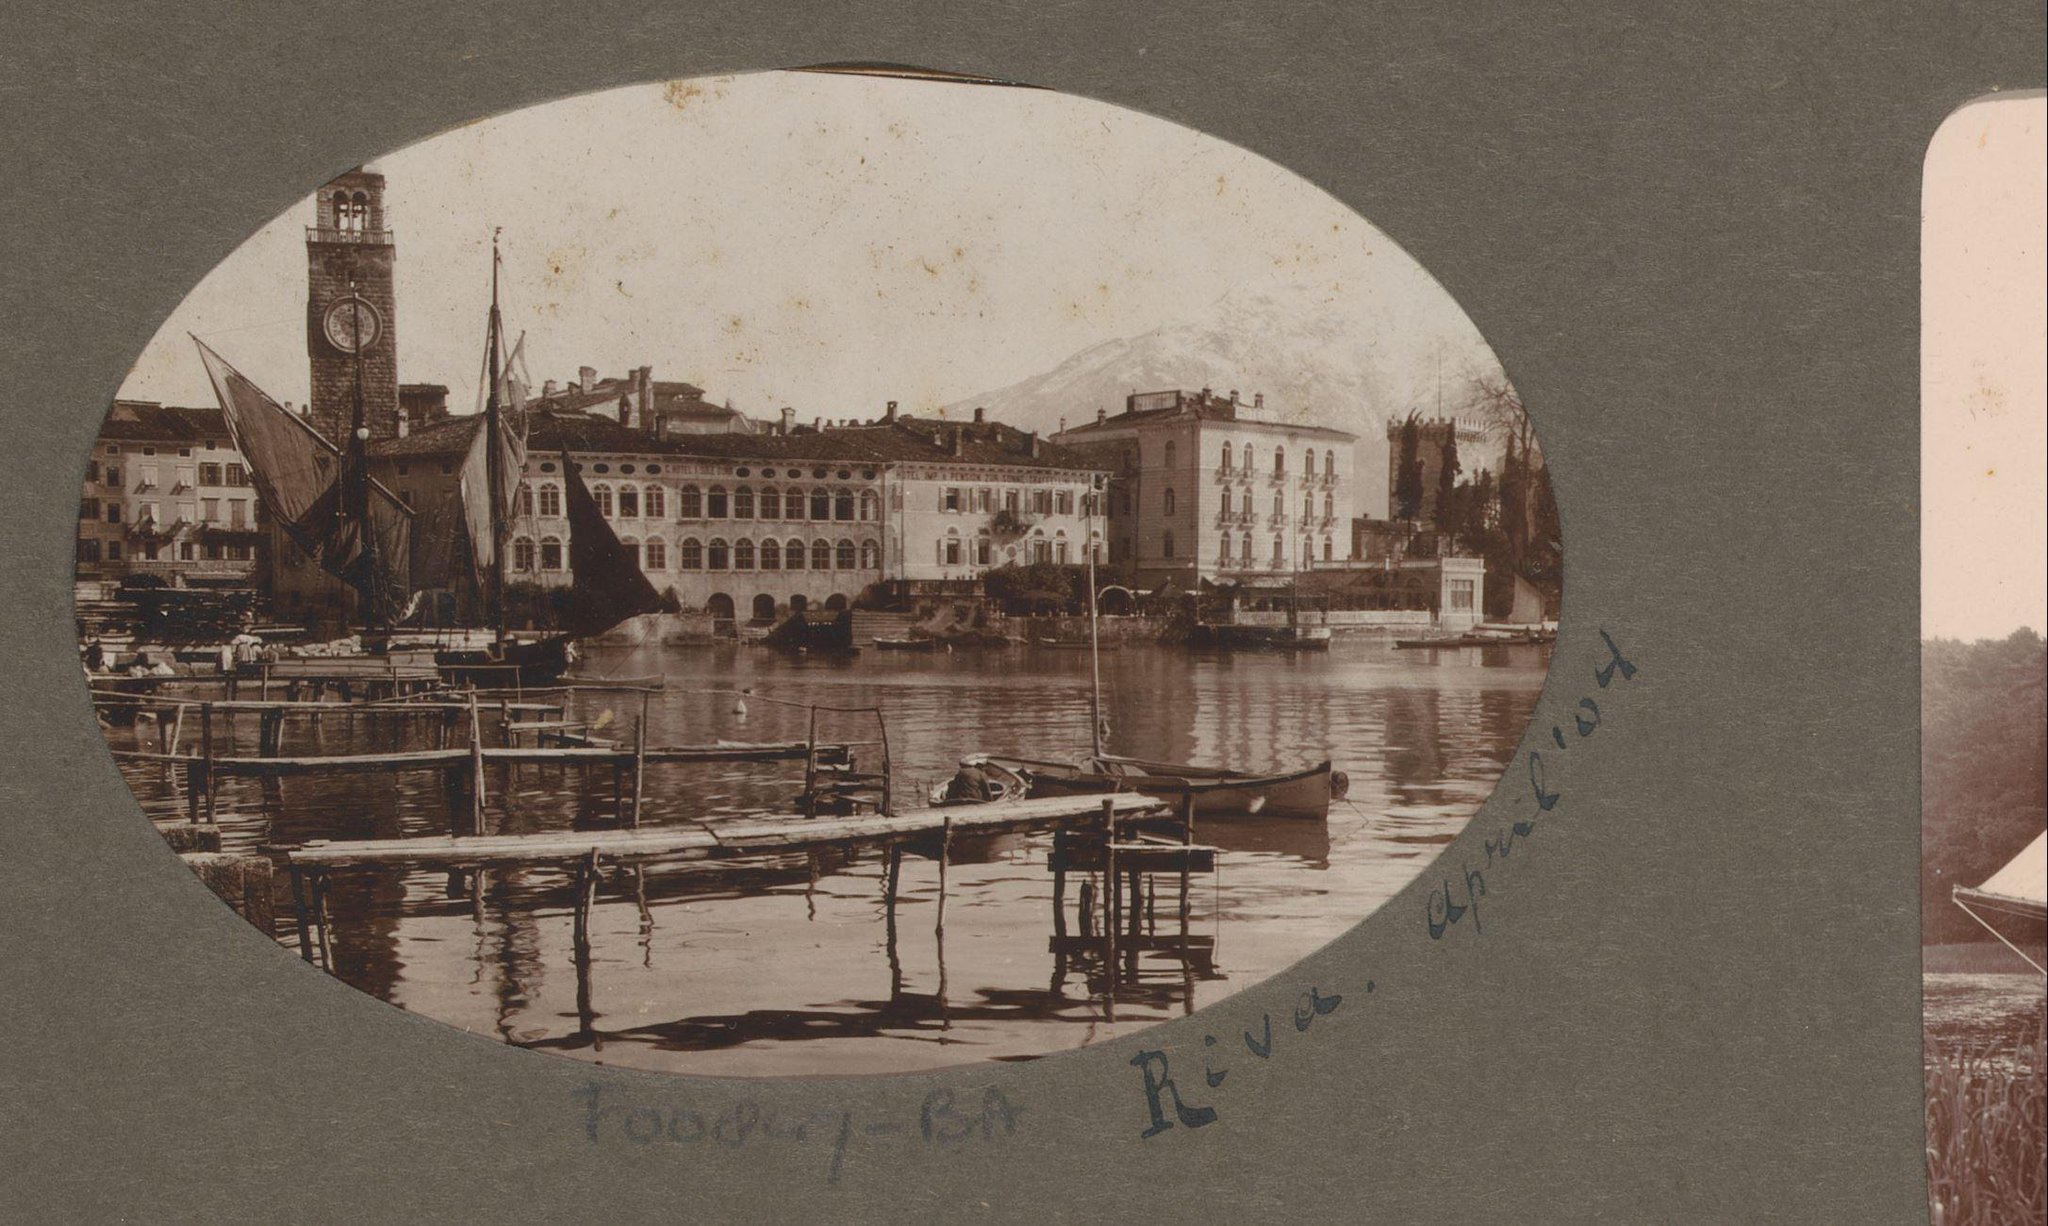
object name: album leaf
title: Gezicht op de haven van Riva del Garda met klokkentoren, gebouwen en omliggende bergen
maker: Anonymous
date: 1902-1906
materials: cardboard, paper, photographic support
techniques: collodion silver print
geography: riva del garda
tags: prospect of village, silhouette of village, tower, clock tower ~ monumental adornment, harbour (+ view ~ vehicle, ship, etc.)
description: Onderdeel van Reisalbum van een Nederlandse familie met bezienswaardigheden in Europa, Egypte en New York.